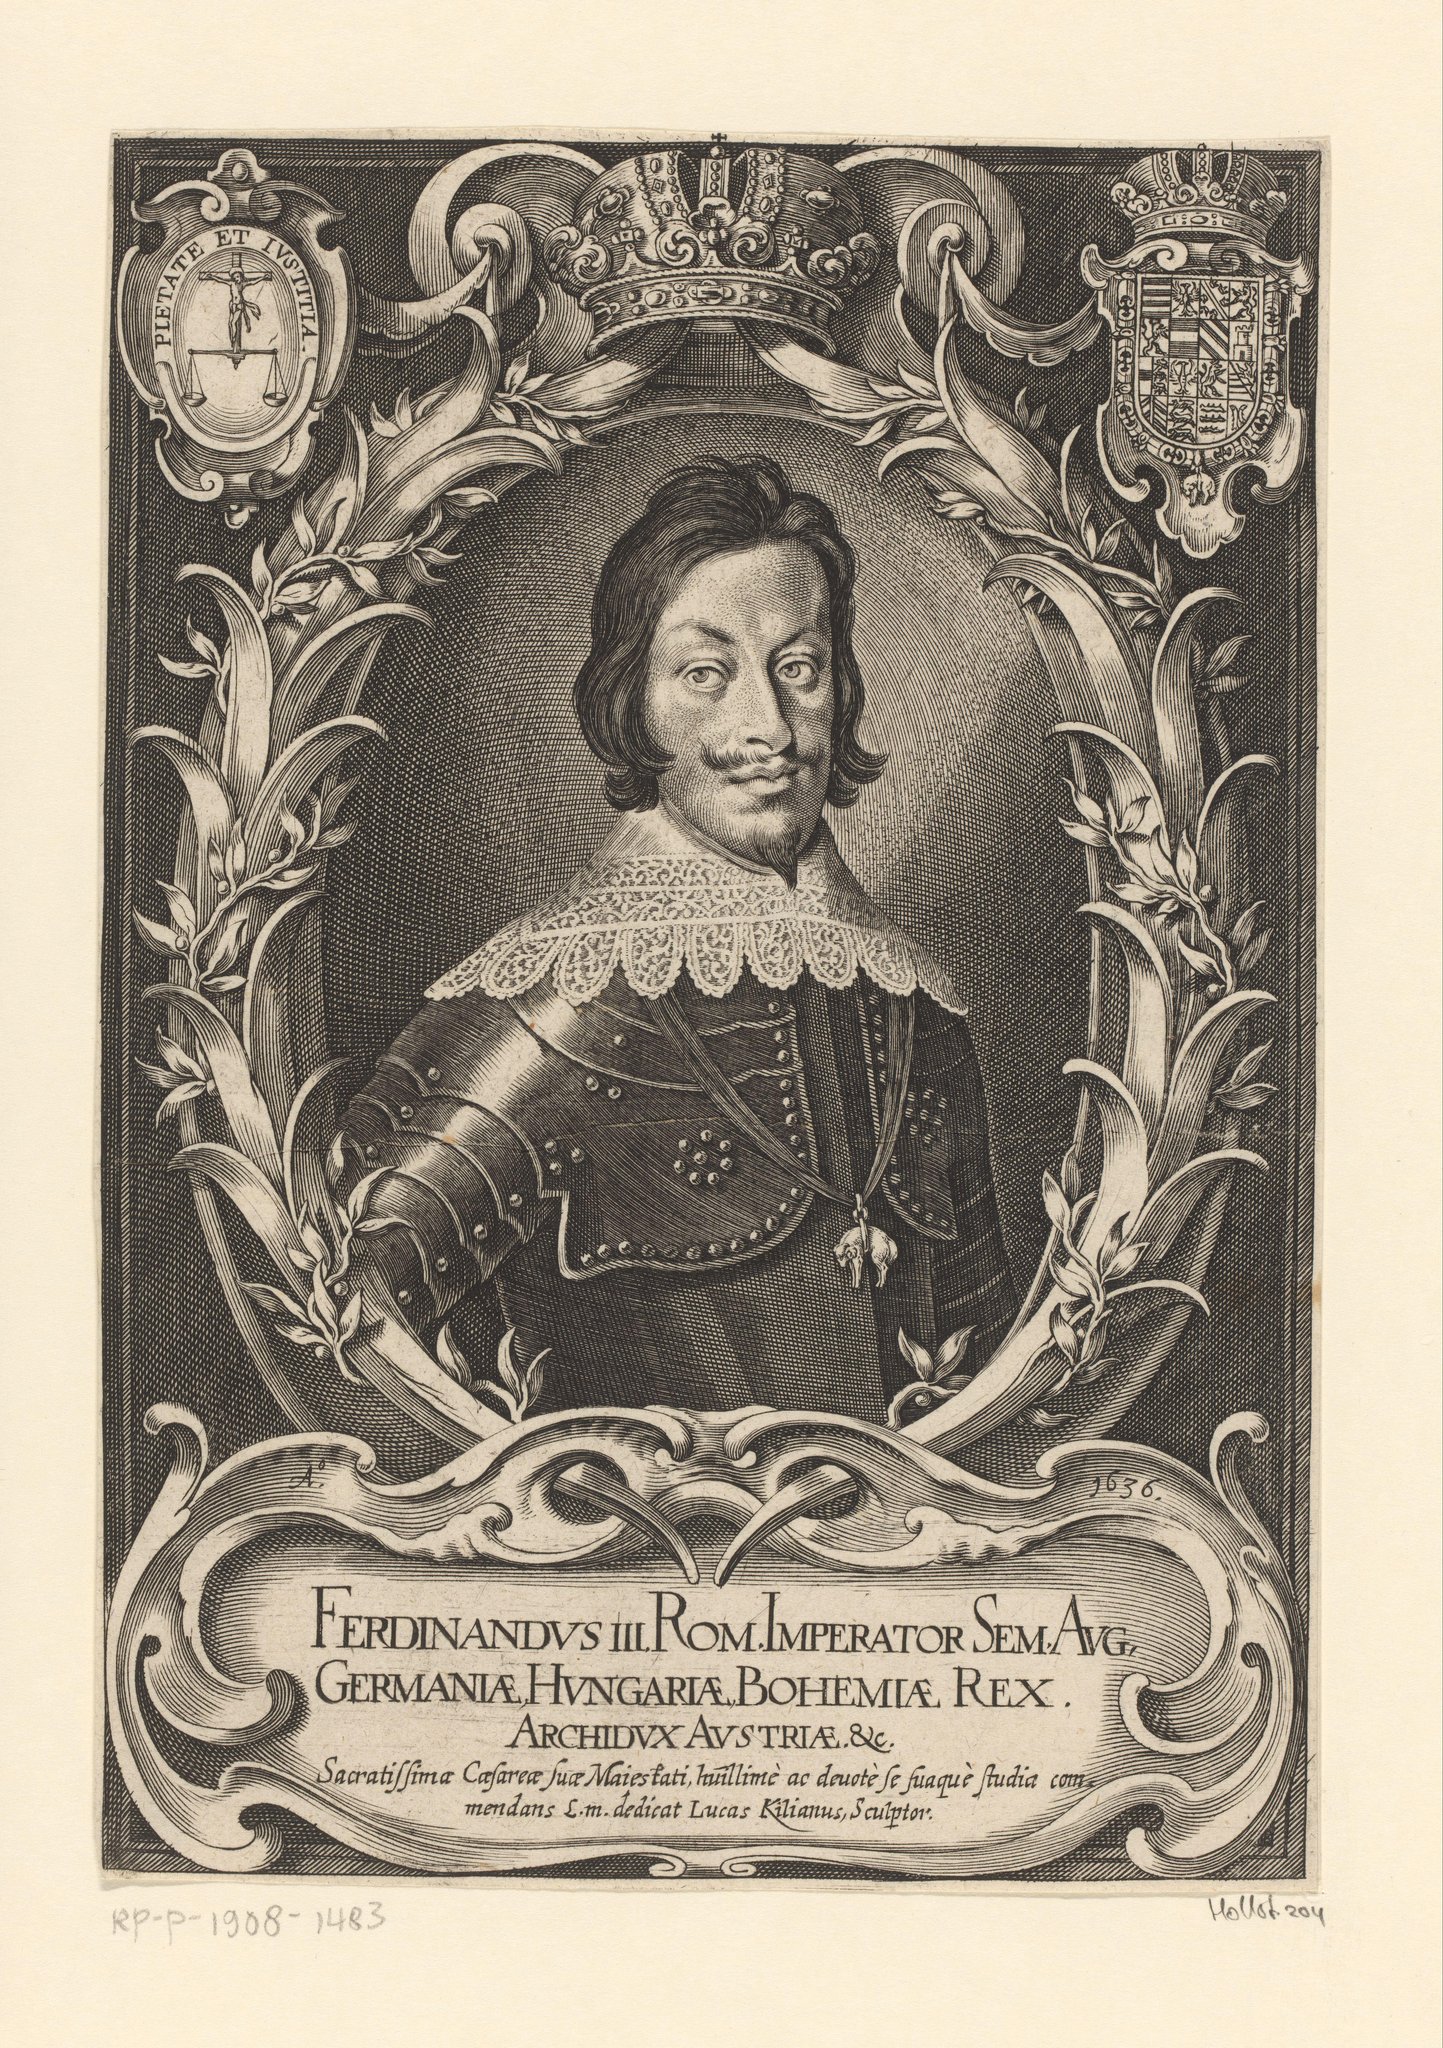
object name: print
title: Portret van keizer Ferdinand III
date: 1636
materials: paper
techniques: engraving, etching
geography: augsburg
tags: vienna, ferdinand iii (duits keizer), historical persons, ruler, sovereign, knighthood order of the golden fleece - insignia of a knighthood order, e.g.: badge, chain (with name of order)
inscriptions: collector's mark: Lugt 2228